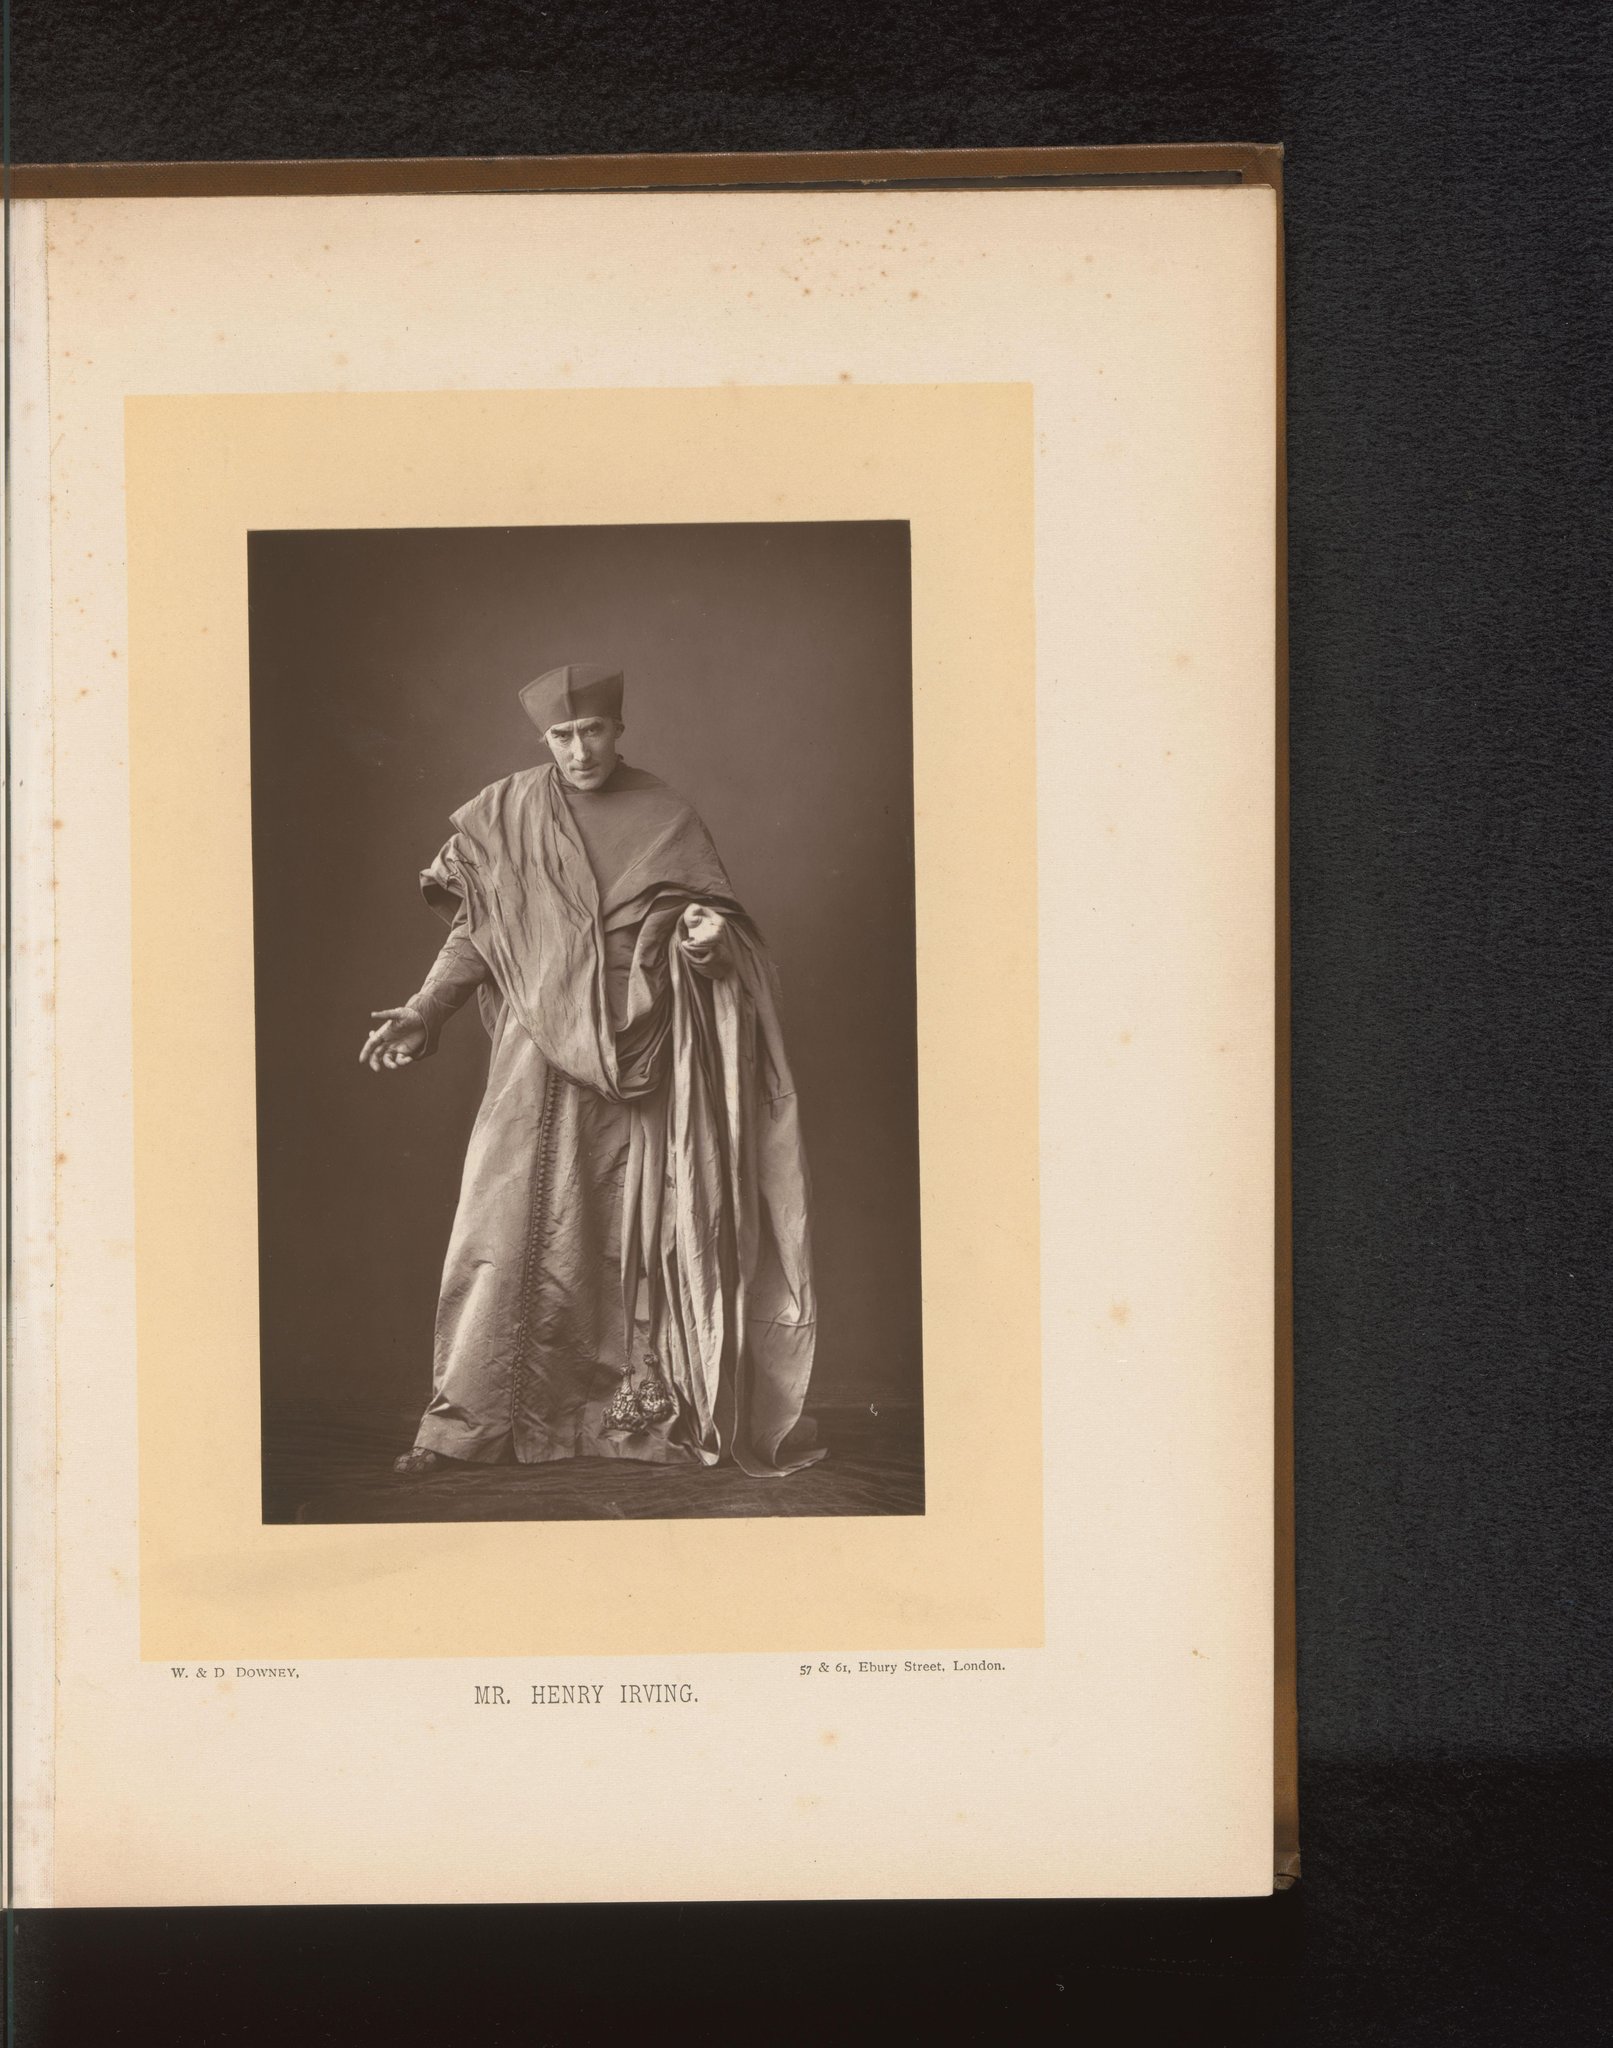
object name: photomechanical print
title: Portret van Henry Irving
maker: Anonymous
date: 1883-1893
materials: paper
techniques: woodburytype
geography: london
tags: stage costume, portrait of actor, actress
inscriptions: inscription: ‘57 & 61, Elbury Street, London.’